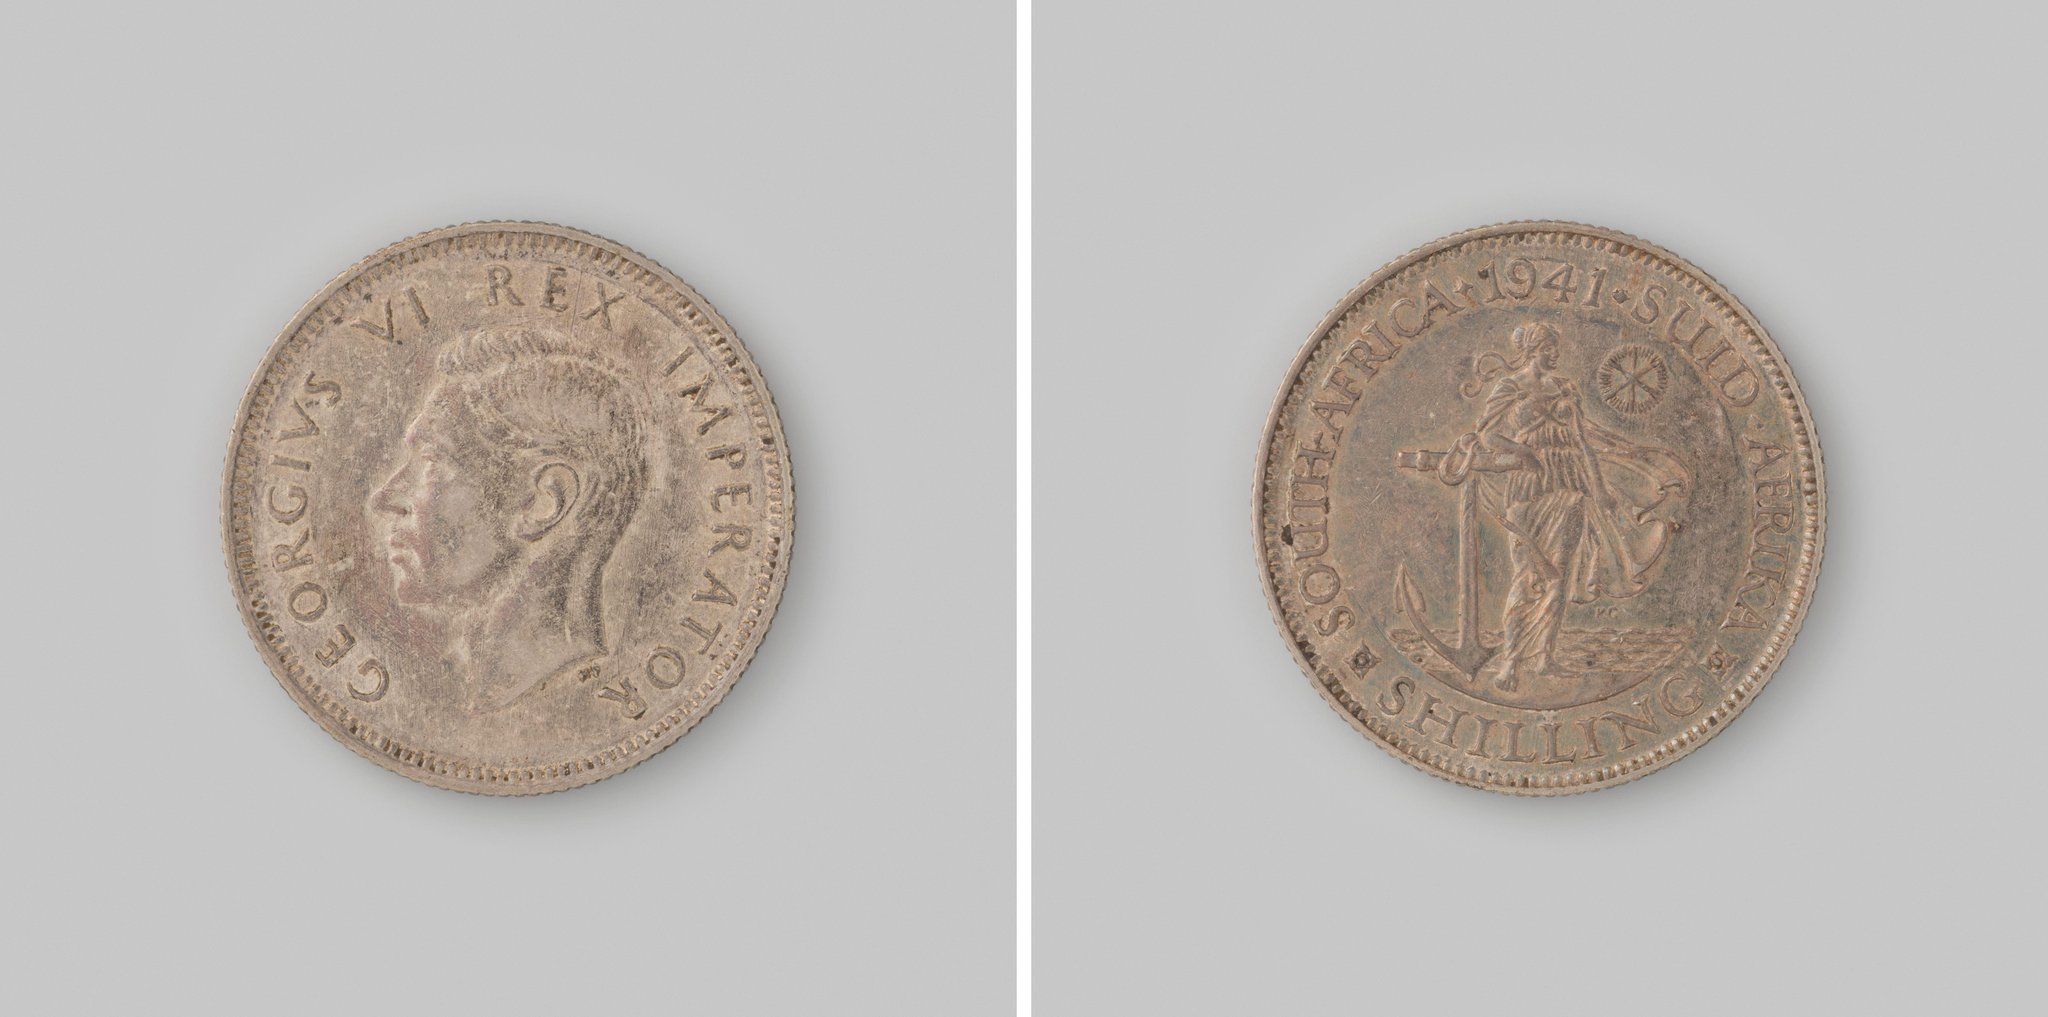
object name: coin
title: Shilling van Zuid-Afrika, 1941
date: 1941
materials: silver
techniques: striking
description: Zilveren munt. Voorzijde: borstbeeld van de Britse koning en keizer George VI naar links. Keerzijde: op anker leunende, staande vrouwelijke gedaante met aan haar voeten de zee en rechts achter haar een stralende zon. Jaartal in omschrift bovenaan en waarde-aanduiding: shilling onderaan.